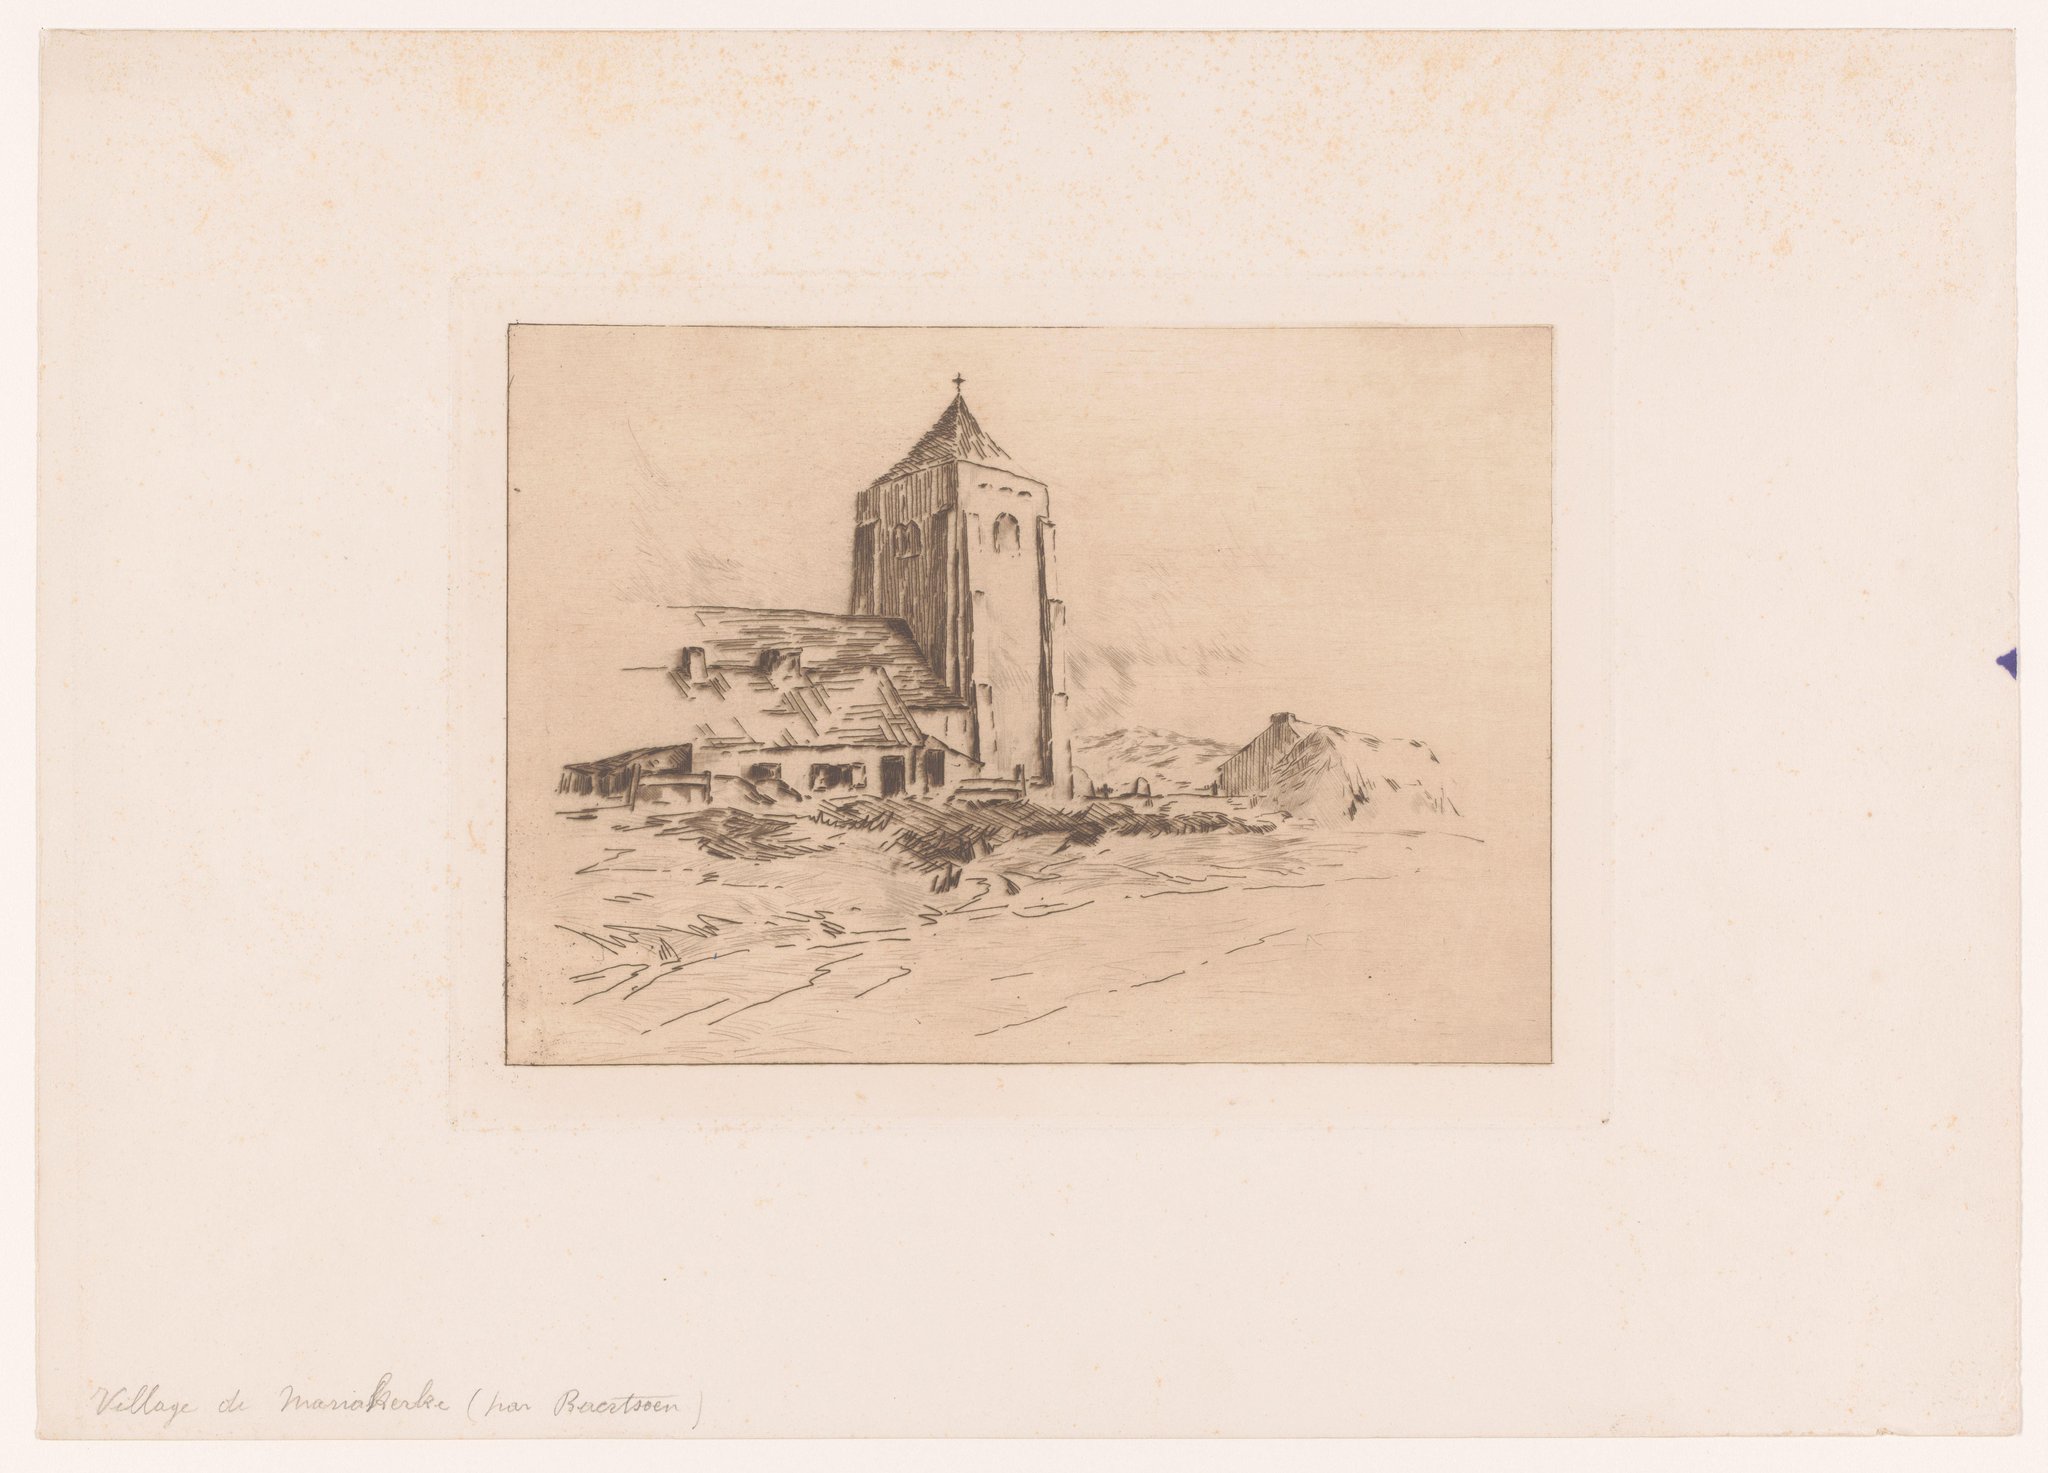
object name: print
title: Gezicht op de Onze-Lieve-Vrouw-ter-Duinenkerk in Mariakerke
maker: albert baertsoen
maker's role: draughtsman, print maker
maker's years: 1866-1922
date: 1876-1909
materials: paper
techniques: drypoint, etching, intaglio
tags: church (exterior)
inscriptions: collector's mark: Lugt 2228